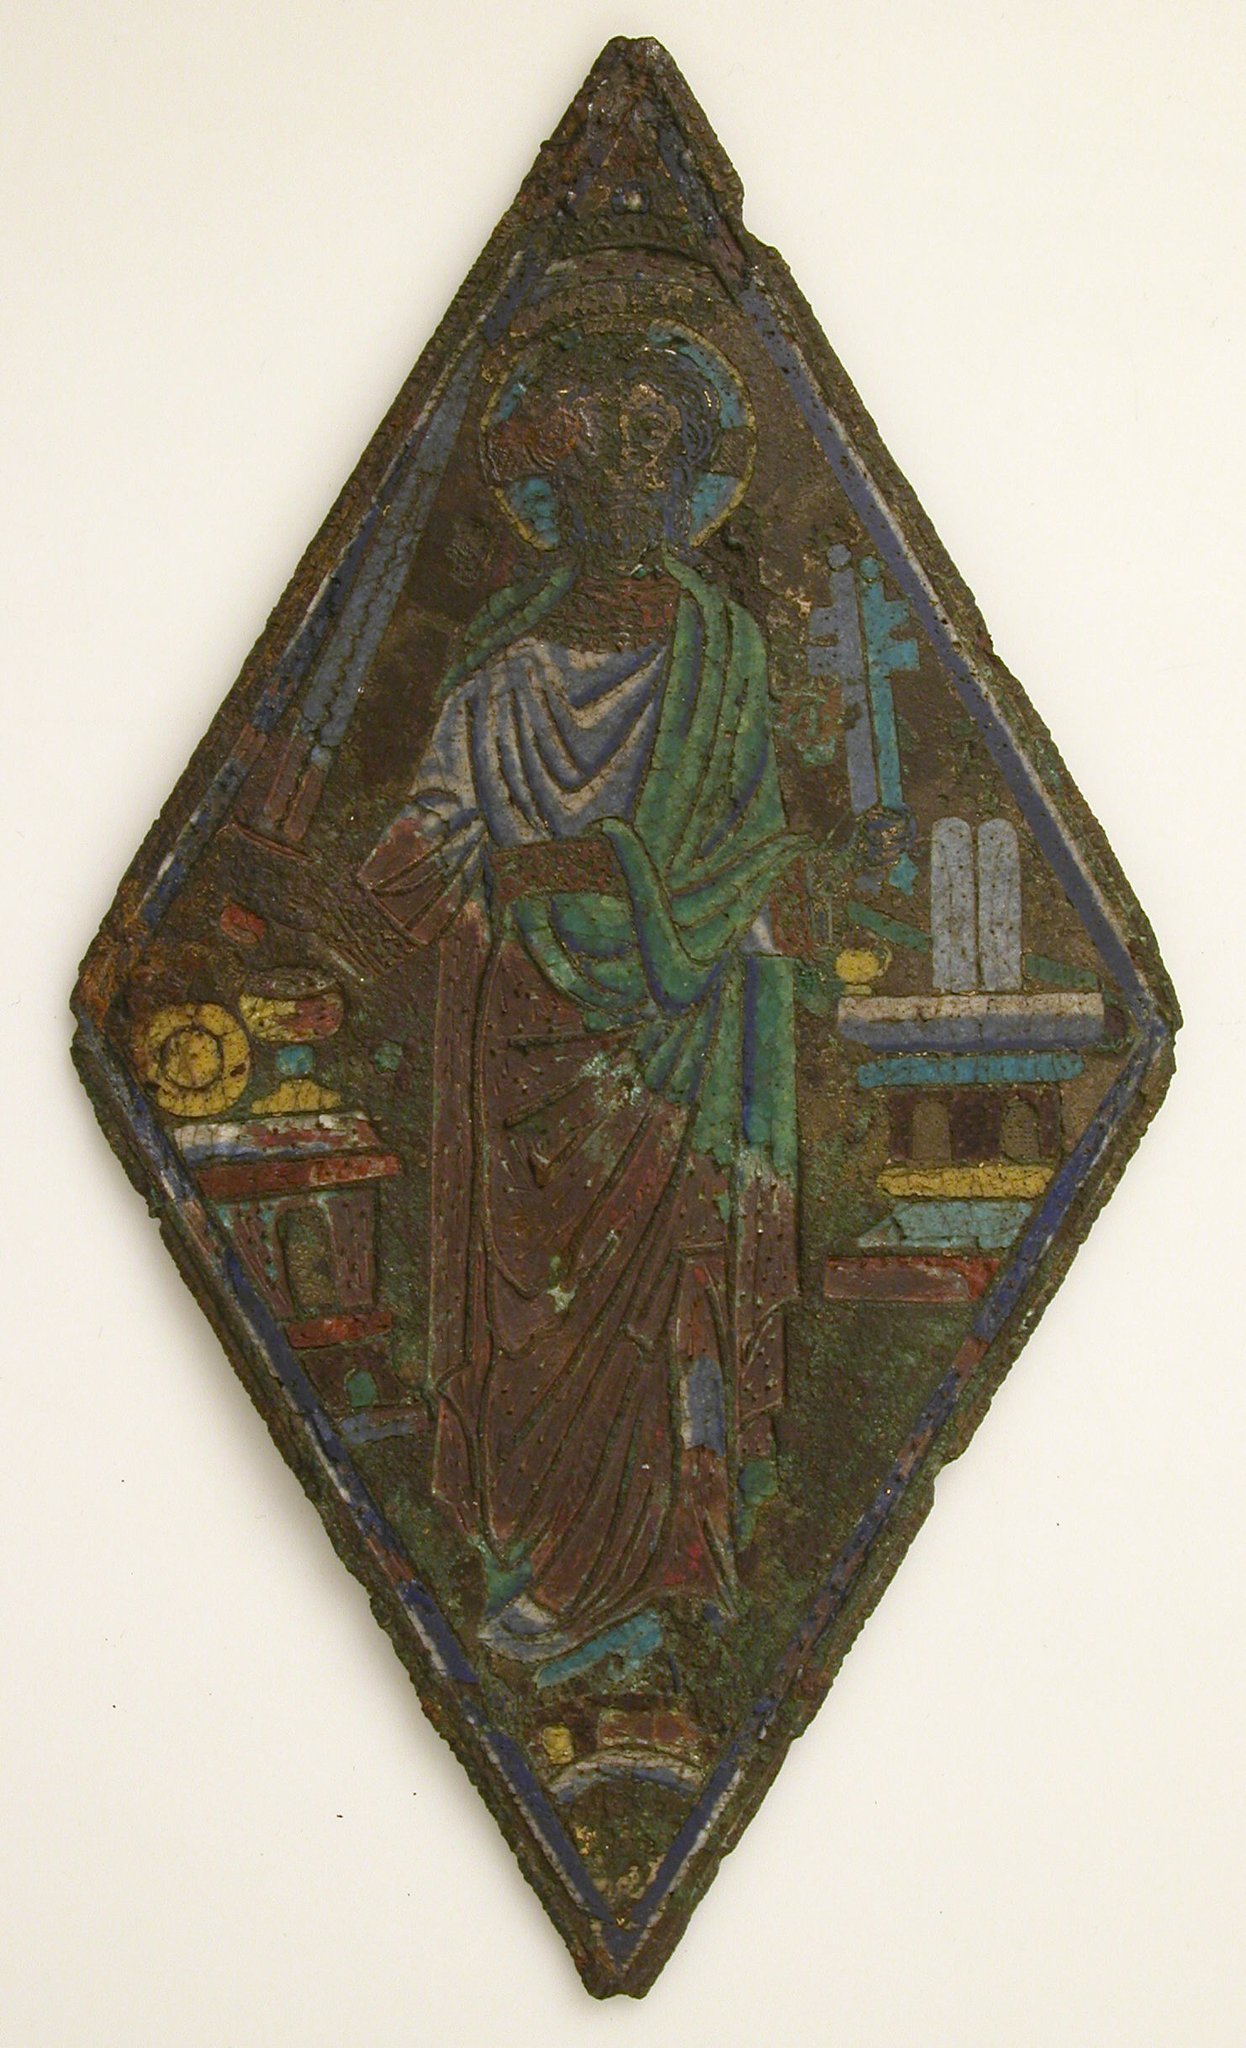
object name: plaque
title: Plaque with Christ as Mediator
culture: mosan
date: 1150-1160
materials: copper, enamel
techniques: enamel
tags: christ